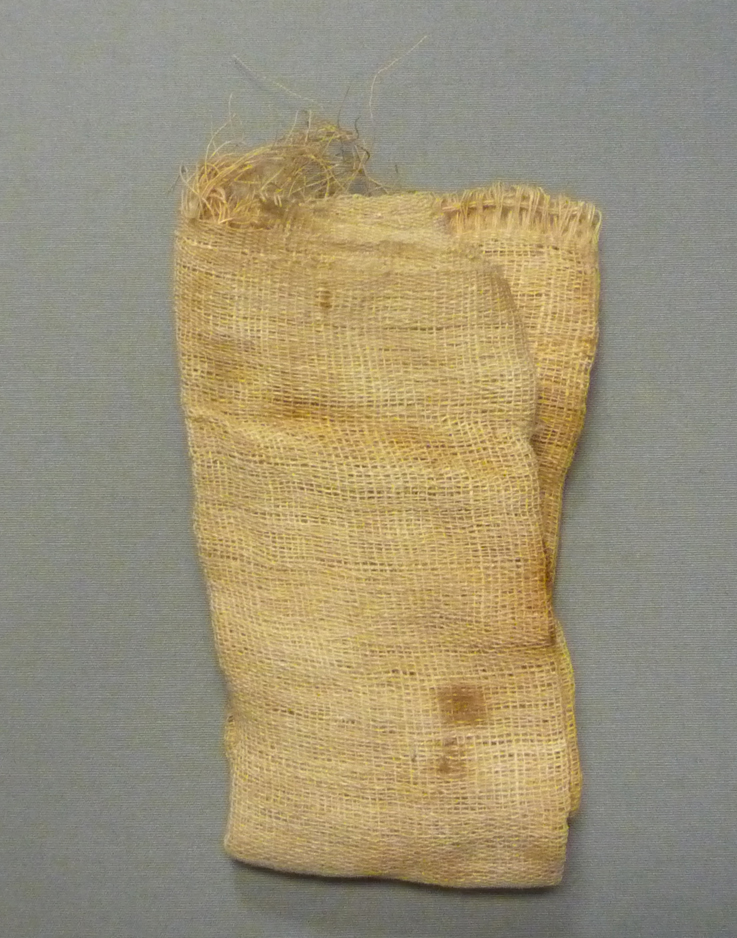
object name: linen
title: Model Sheet from a Foundation Deposit for Hatshepsut's Temple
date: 1479-1458 BCE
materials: linen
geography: egypt